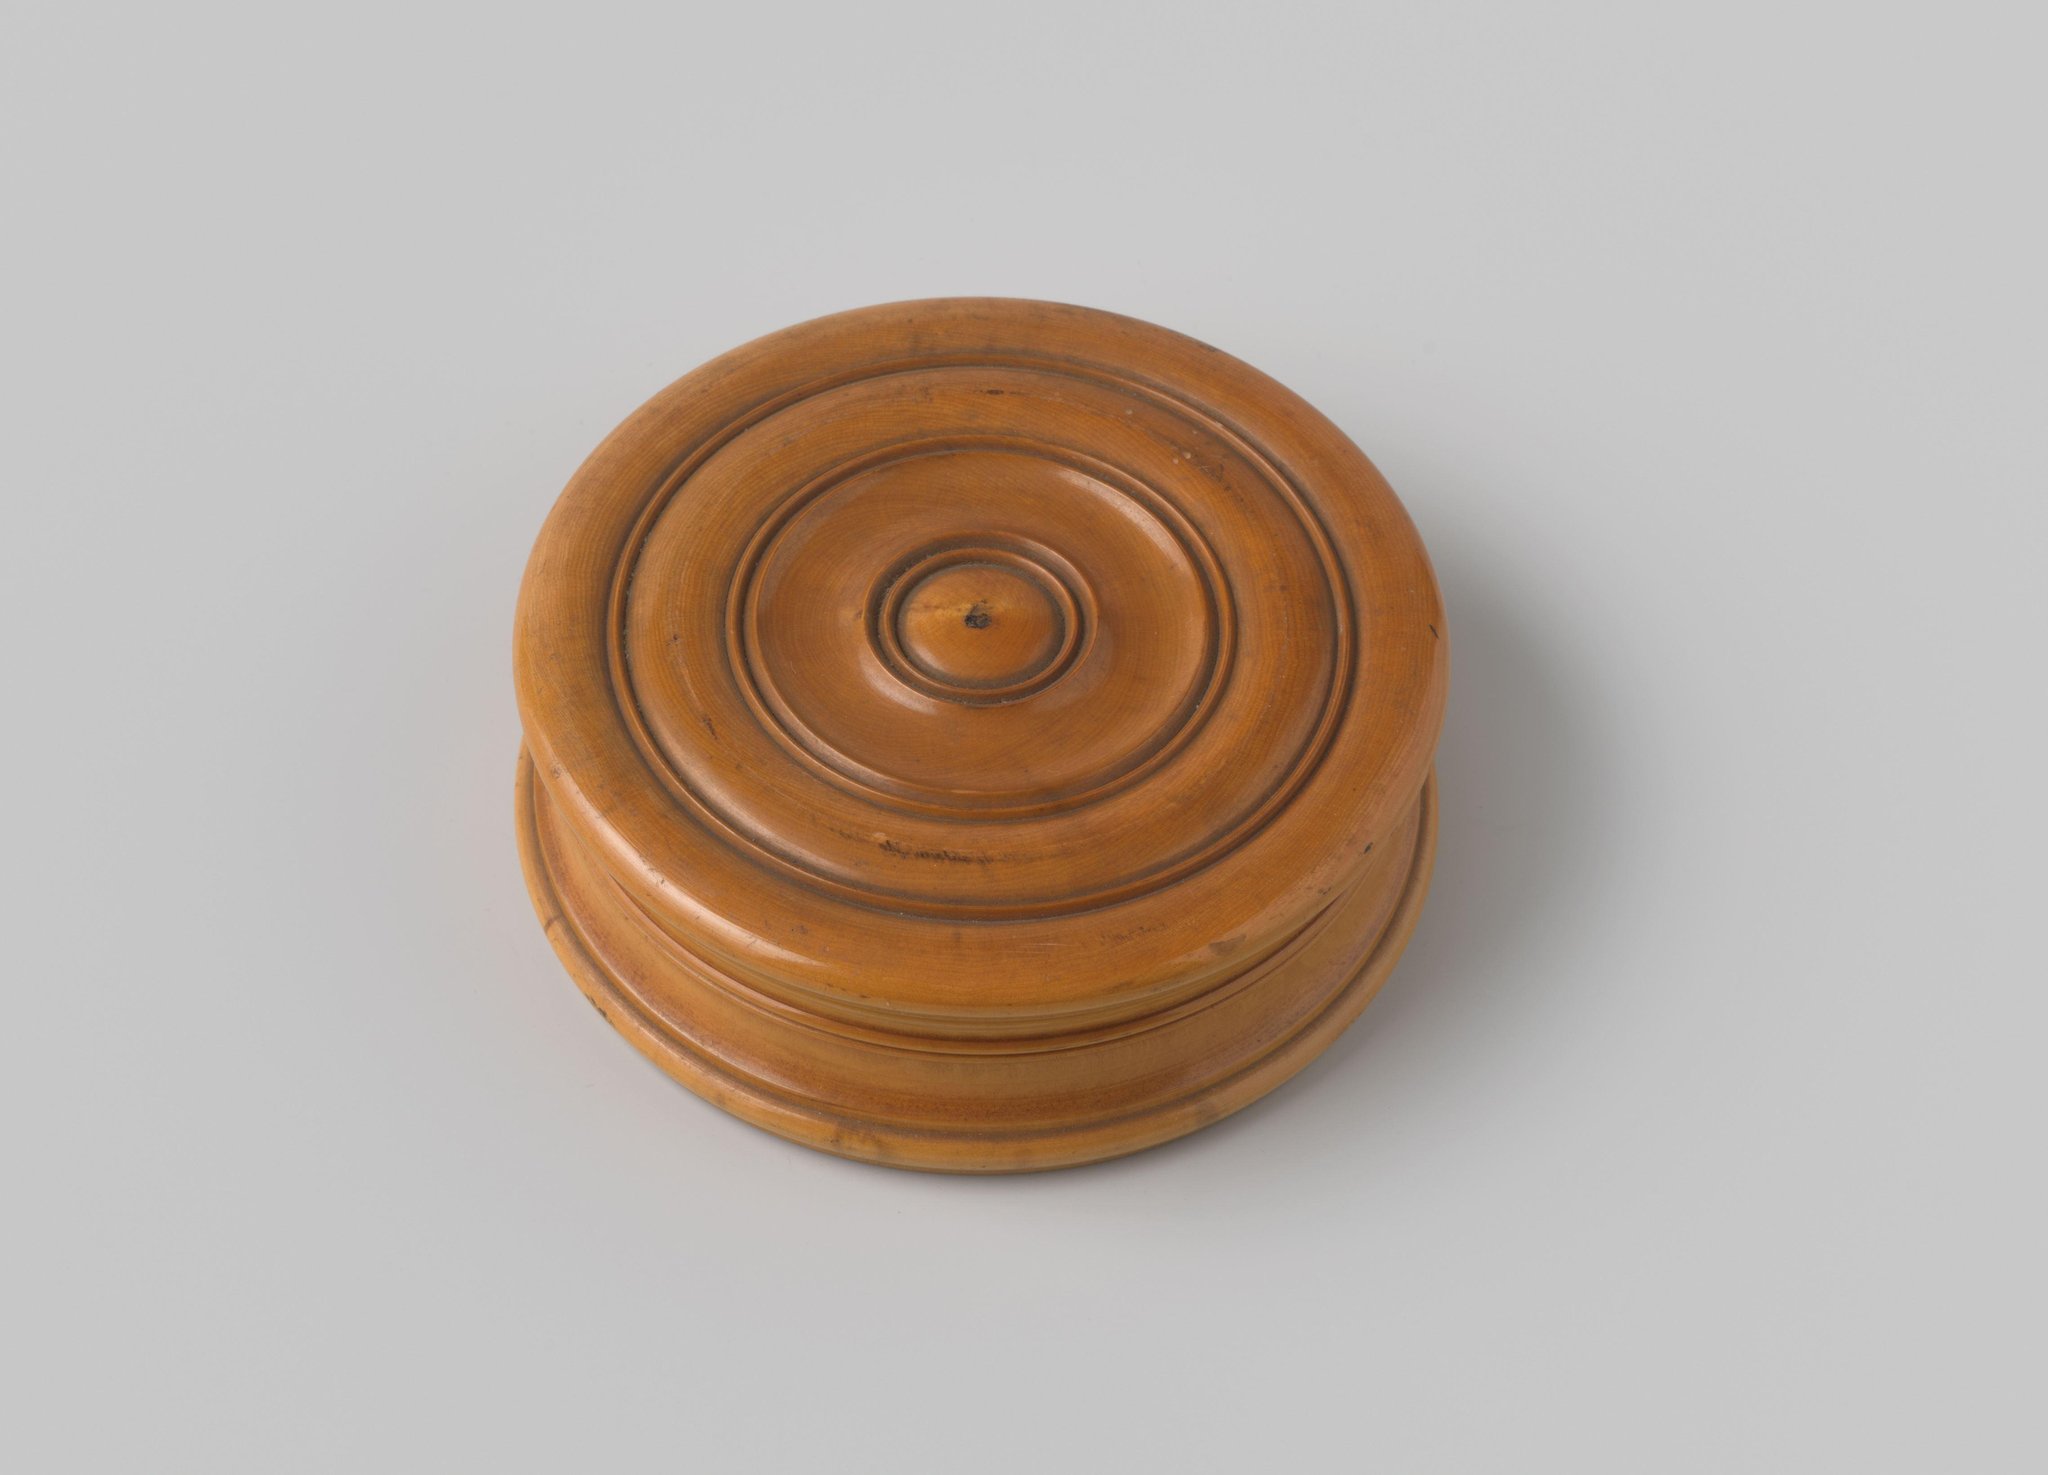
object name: medal box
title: Penningdoos bij gedenkpenning van Isaac Rochussen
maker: Anonymous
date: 1672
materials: wood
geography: netherlands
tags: isaac rochussen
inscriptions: date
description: Houten ronde penningdoos waarop op de onderzijde '35' en geschreven Penning Isaac Rochussen 1672.